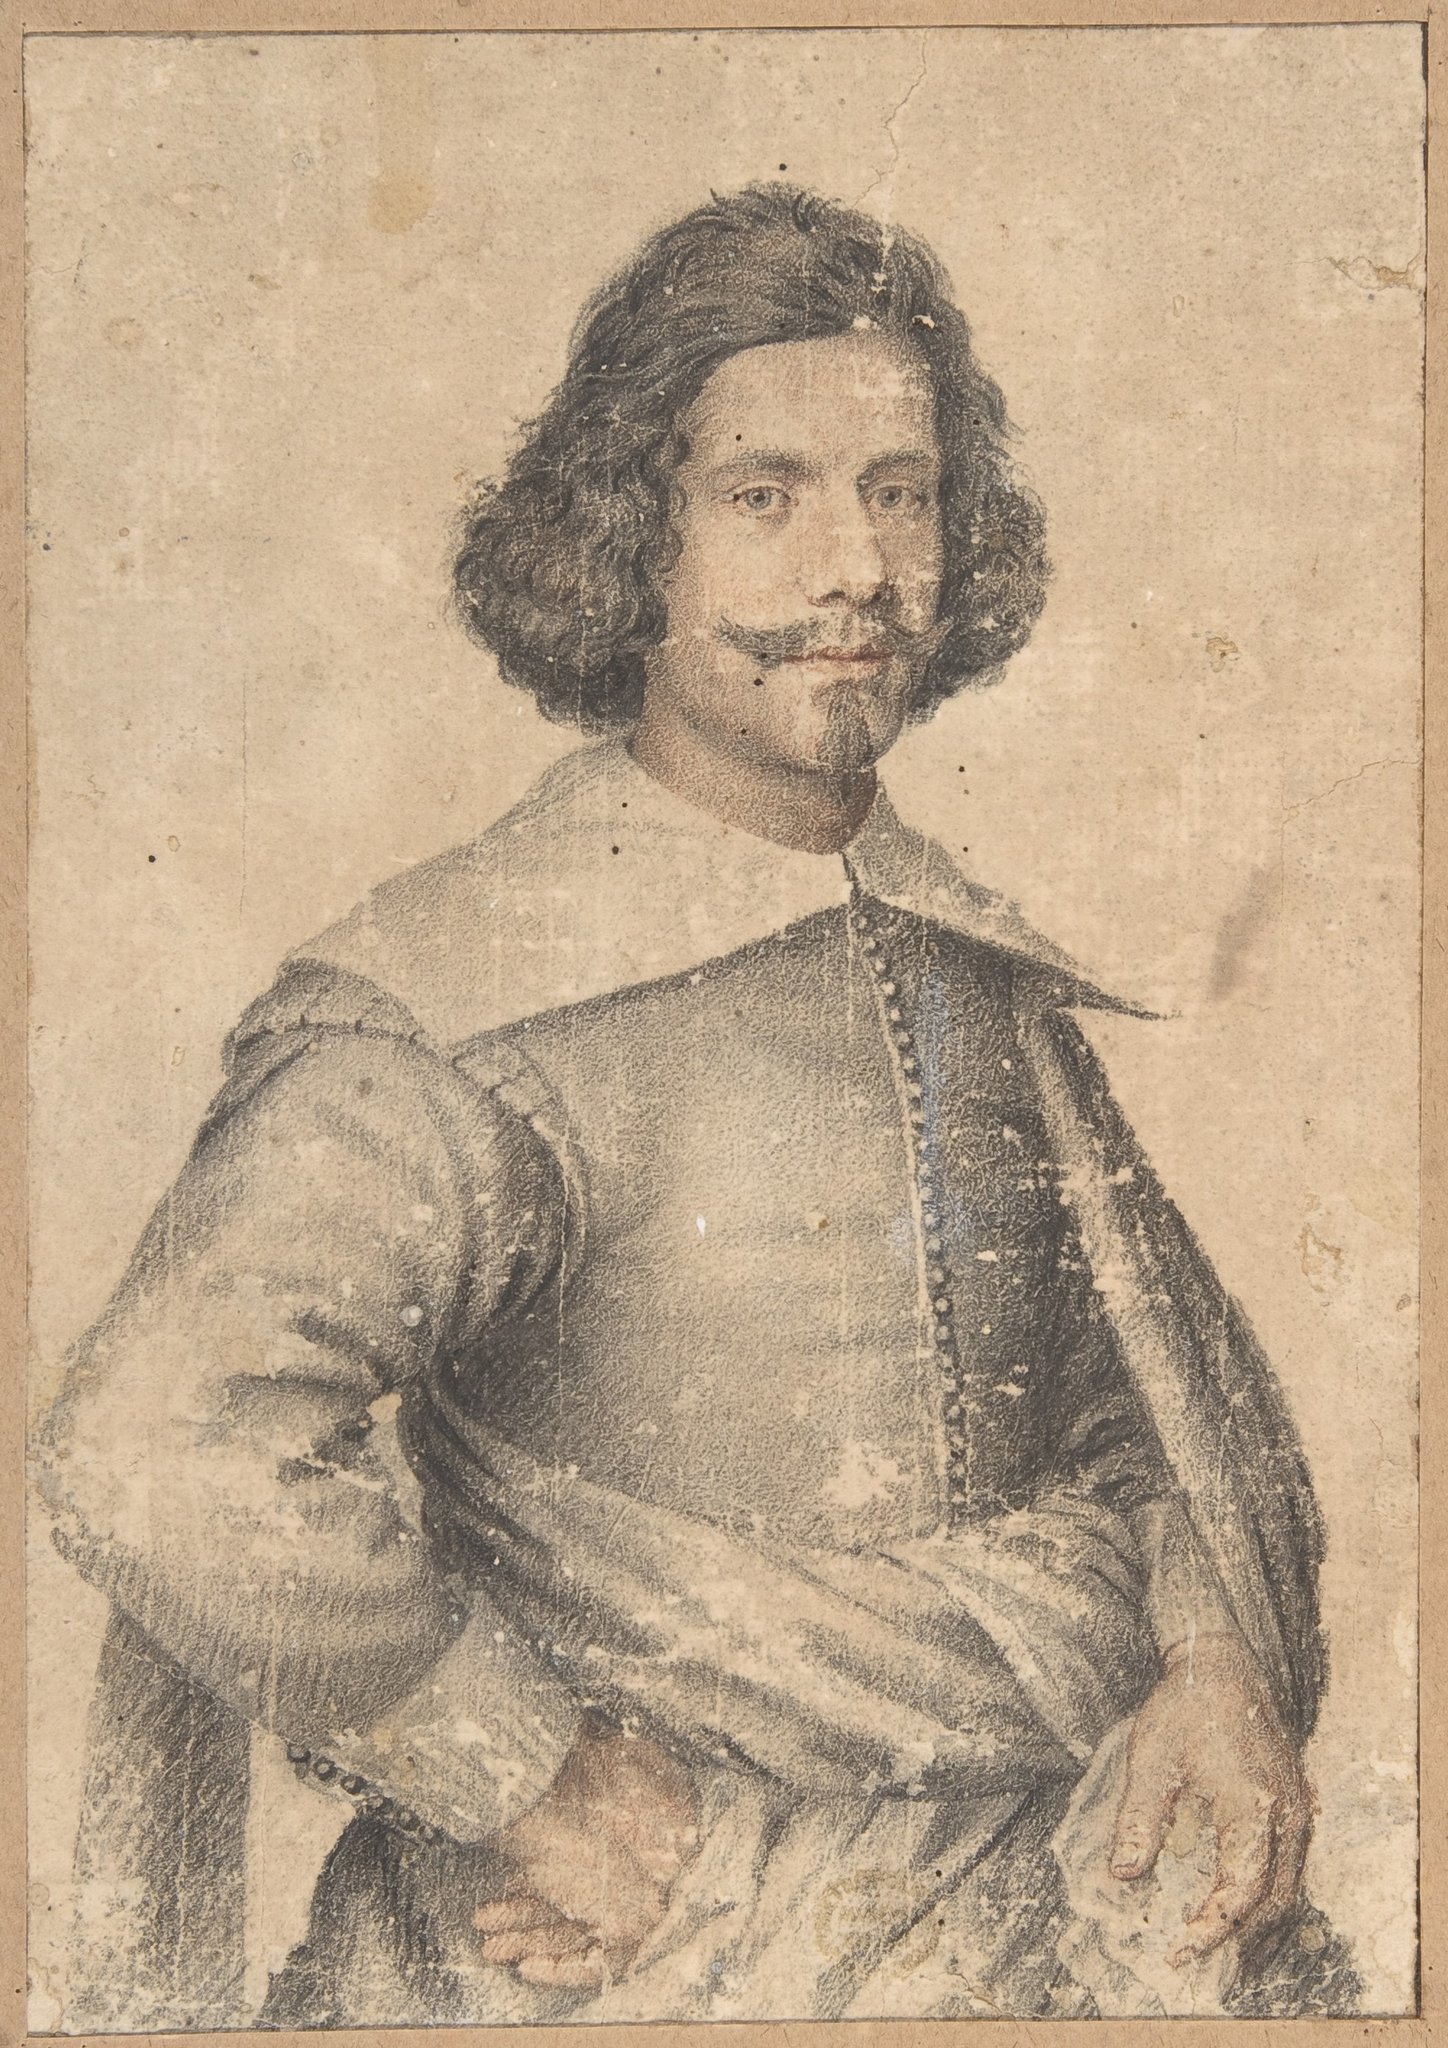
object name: drawing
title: A Portrait of a Man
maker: anonymous, spanish, 17th century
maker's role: artist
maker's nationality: spanish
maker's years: 1600-1700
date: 1601-1700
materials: chalk, paper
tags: men,portraits